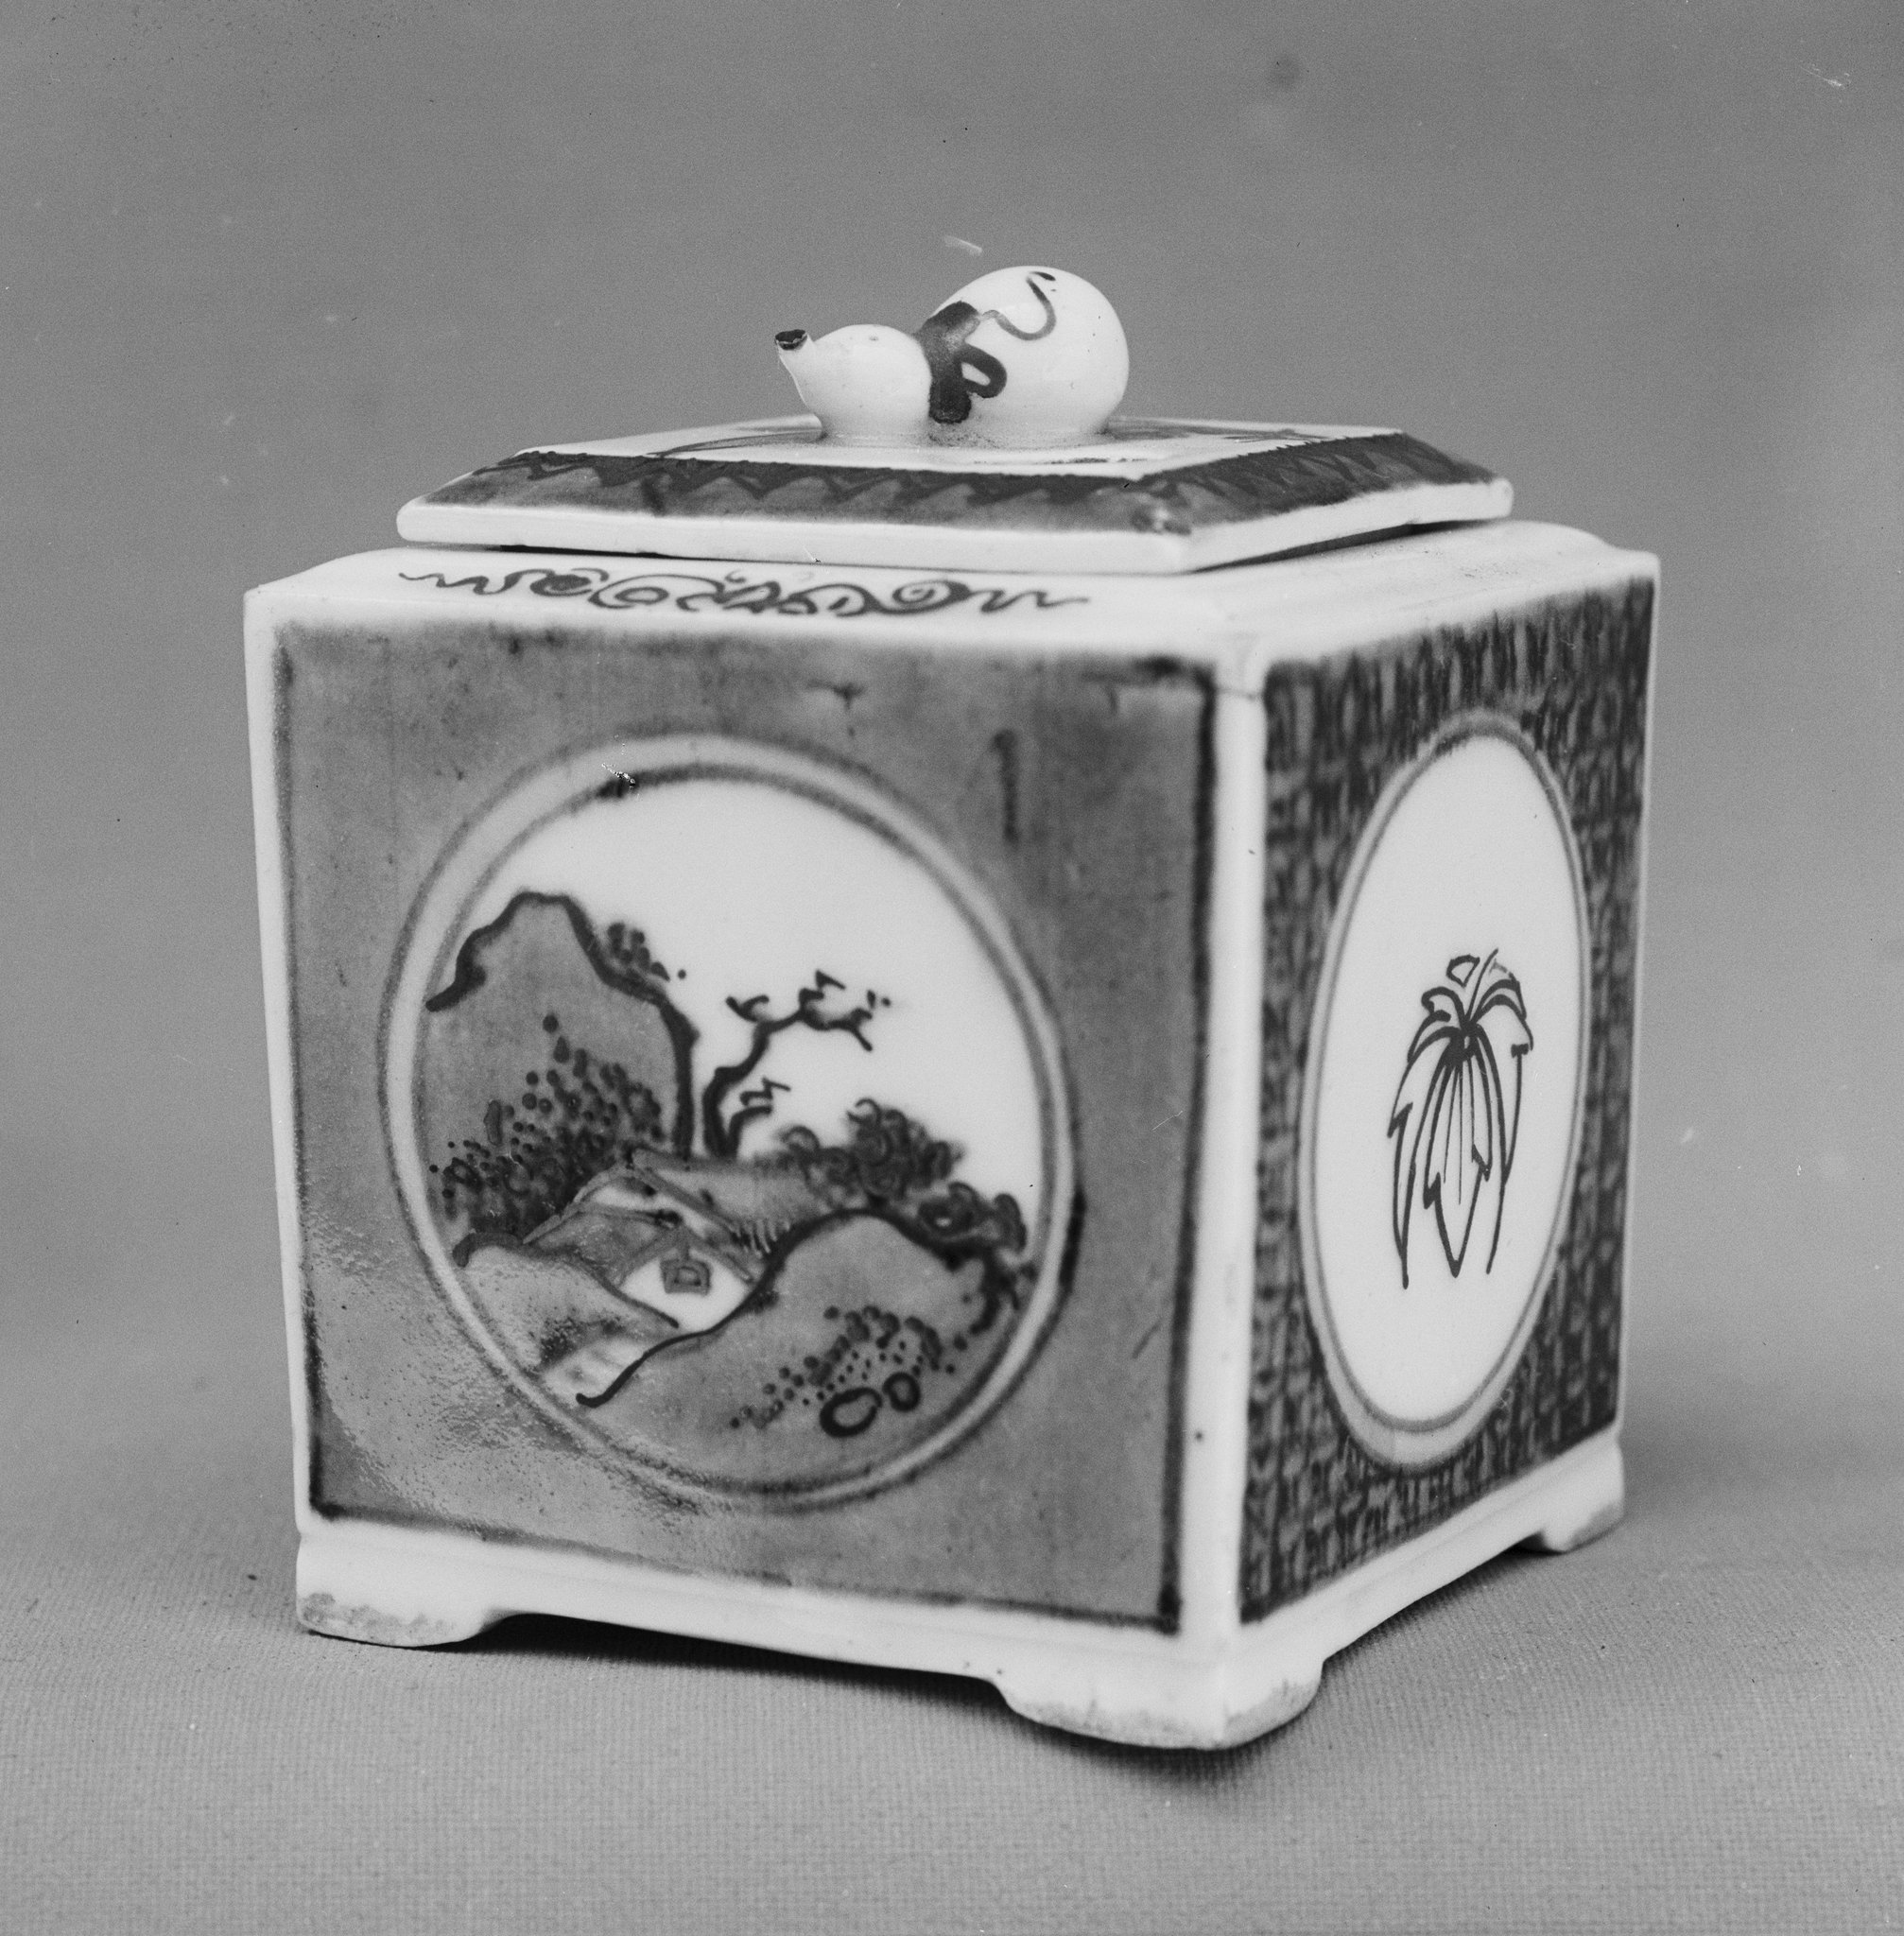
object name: incense burner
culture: japanese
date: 1750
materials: glaze, porcelain